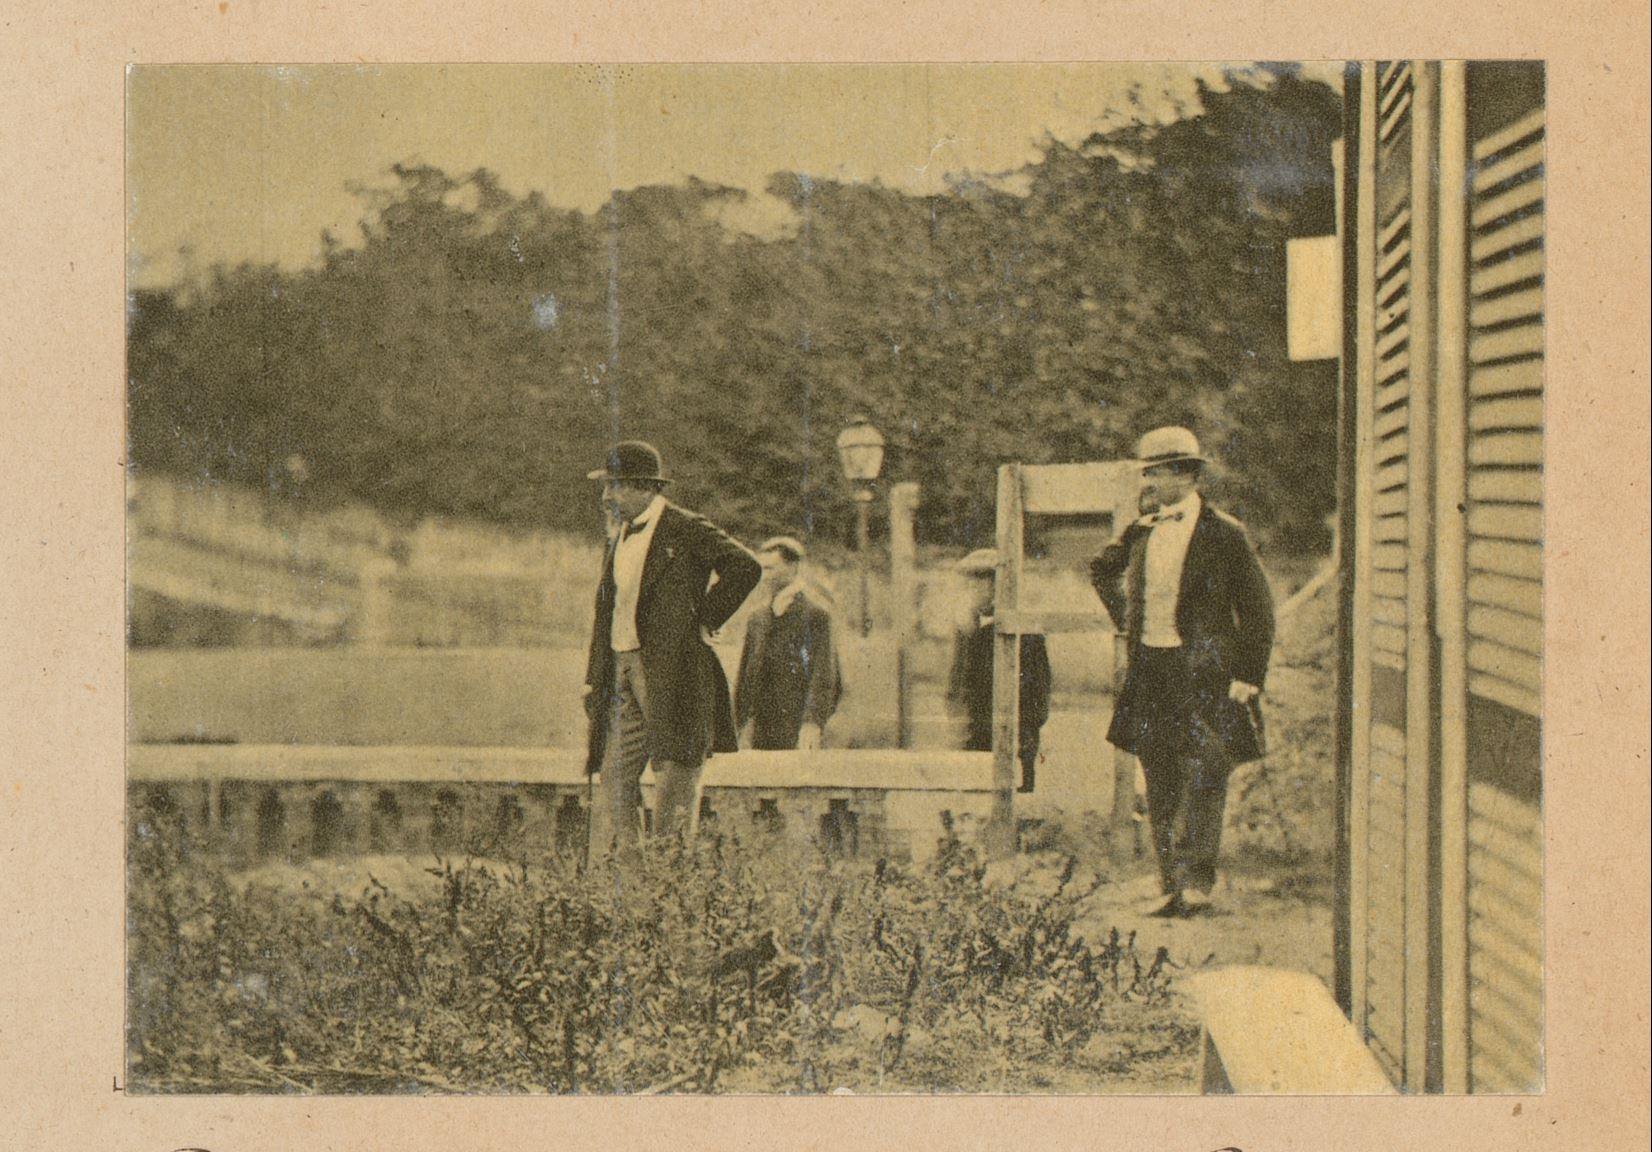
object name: photograph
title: La dernière photographie de l'Empereur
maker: Anonymous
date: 1873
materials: paper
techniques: rotogravure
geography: london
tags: napoleon iii (keizer der fransen), emperor